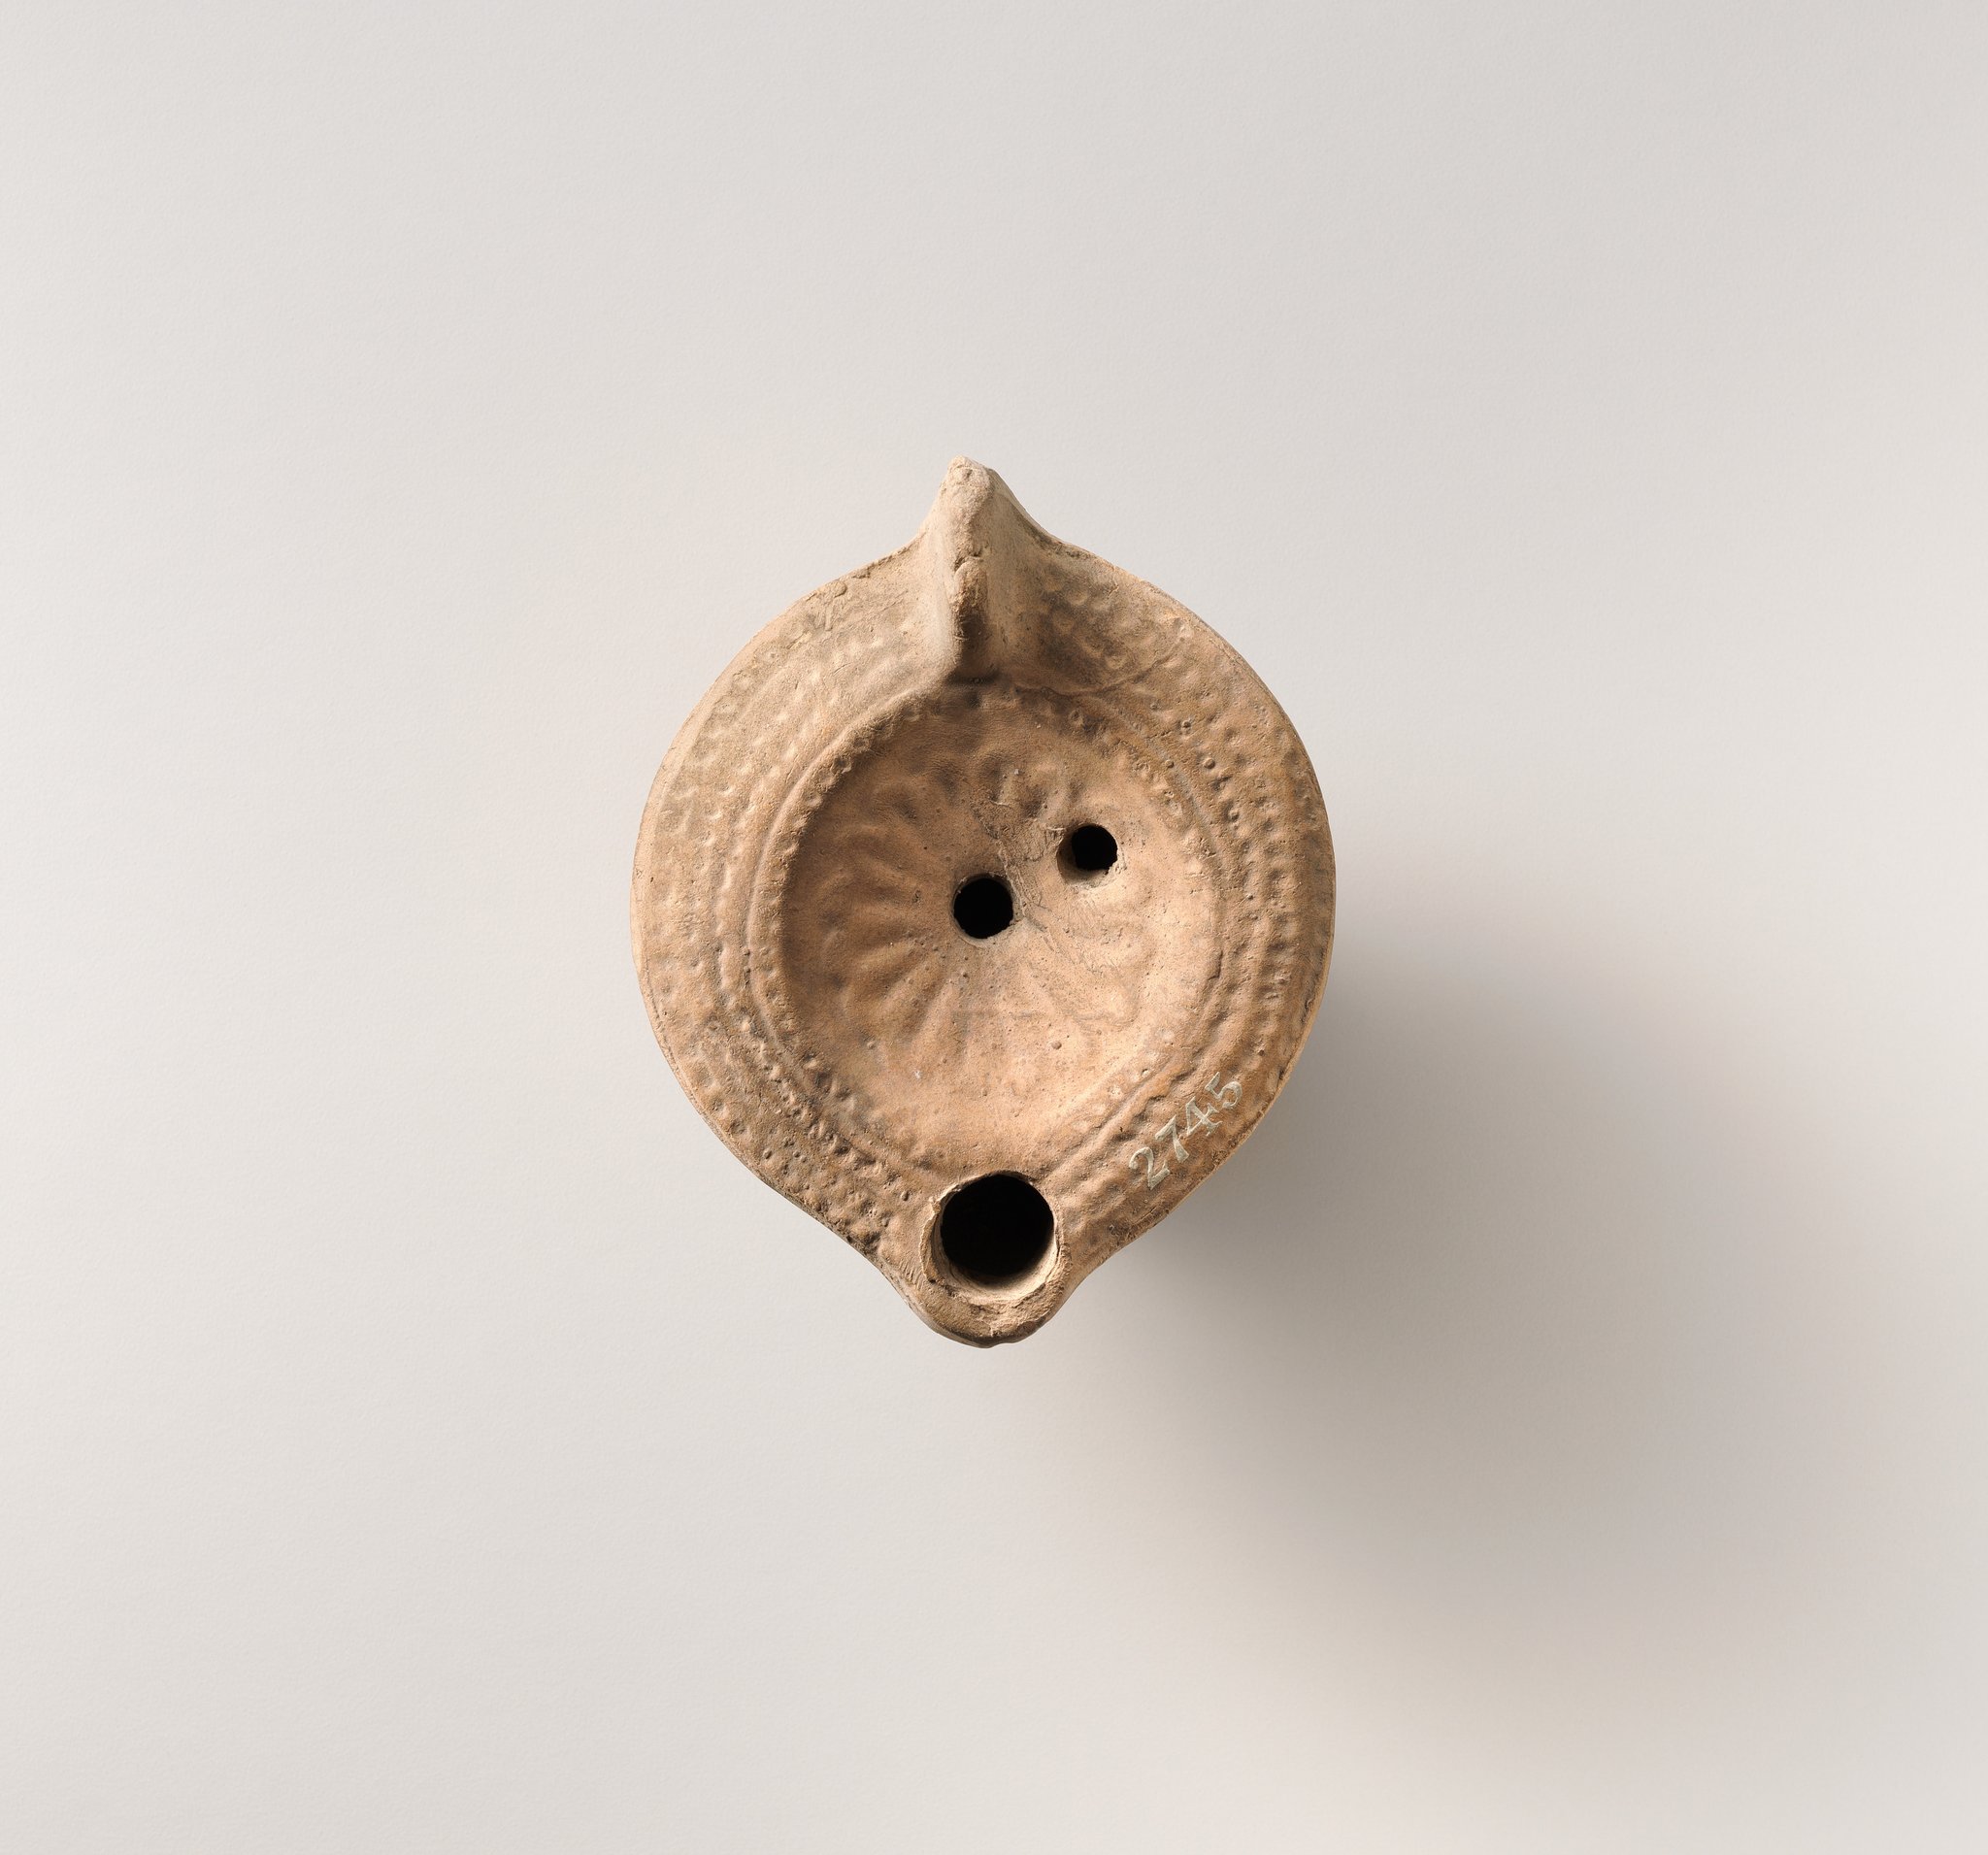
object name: lamp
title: Terracotta oil lamp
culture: roman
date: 101-200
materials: terracotta